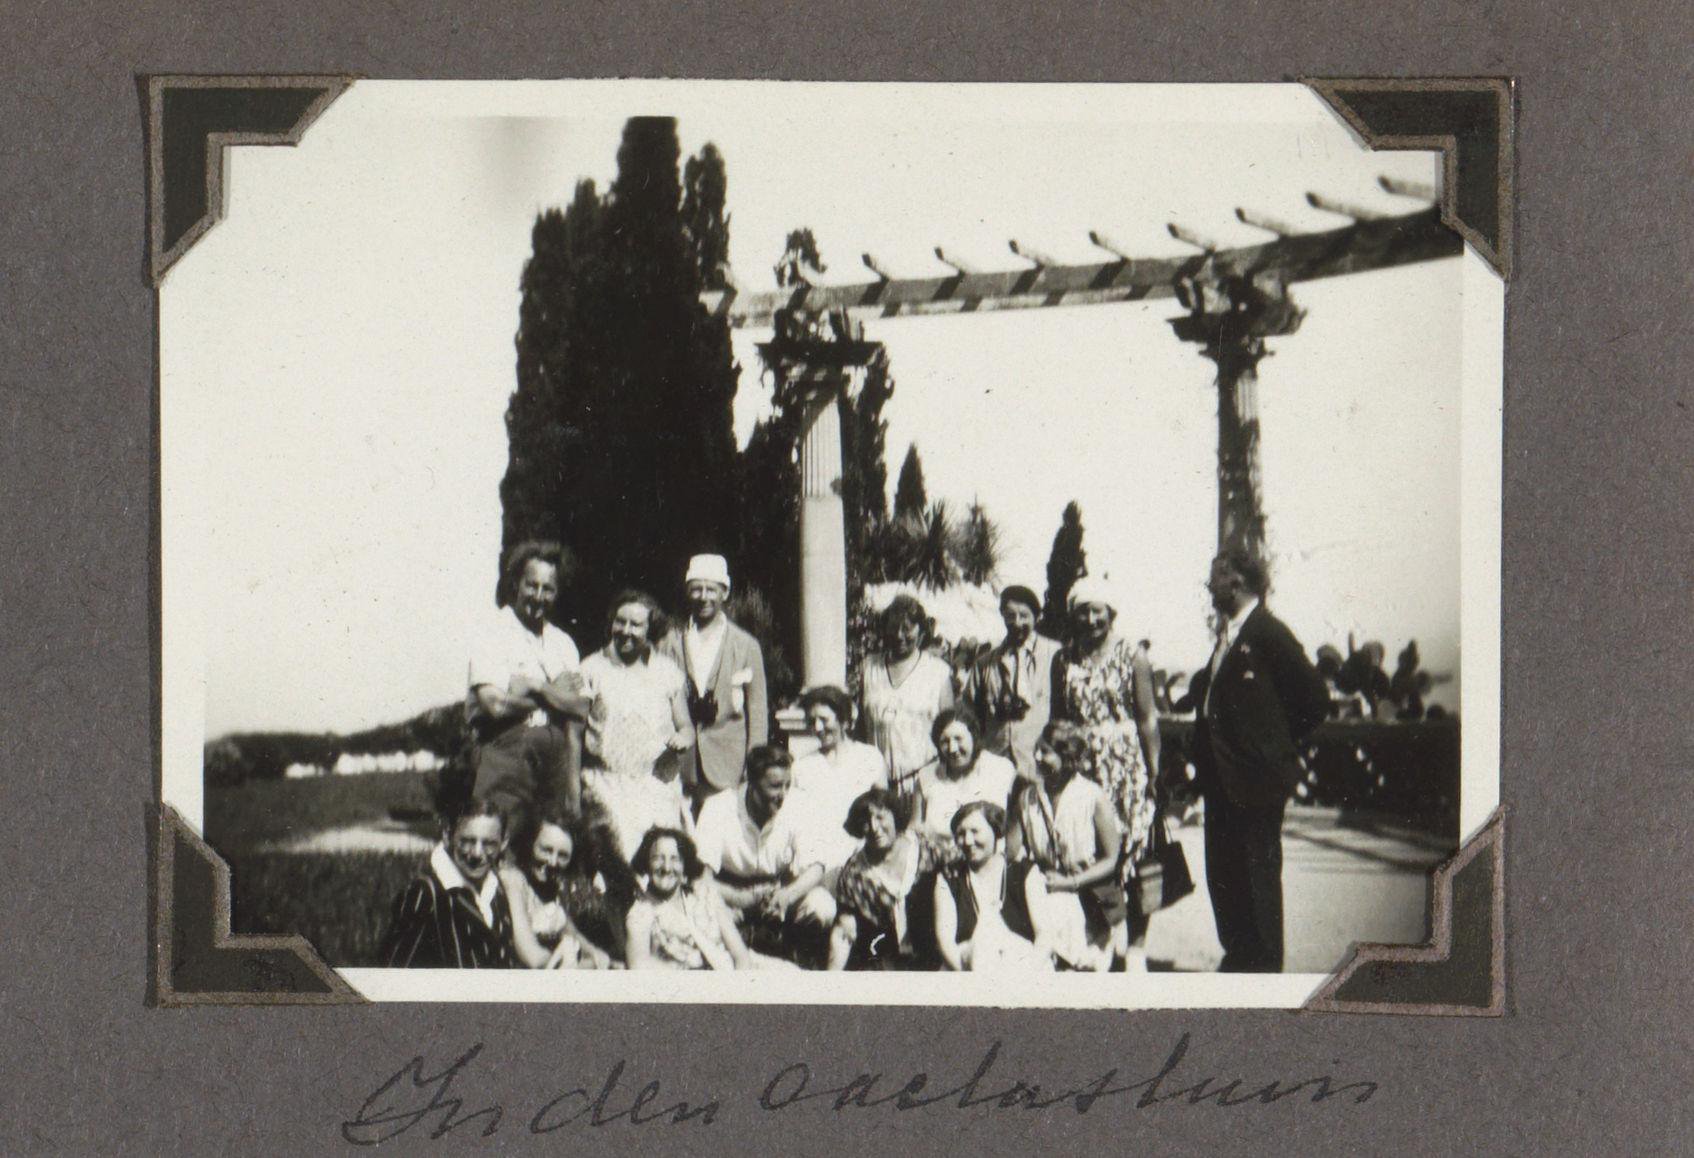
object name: photograph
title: Gezelschap onder een pergola in een hoteltuin in Roquebrune-Cap-Martin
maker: Anonymous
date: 1930-1935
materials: photographic support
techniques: gelatin silver print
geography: roquebrune-cap-martin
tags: pergola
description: Onderdeel van Fotoalbum met opnames van vakanties in Zuid-Frankrijk.